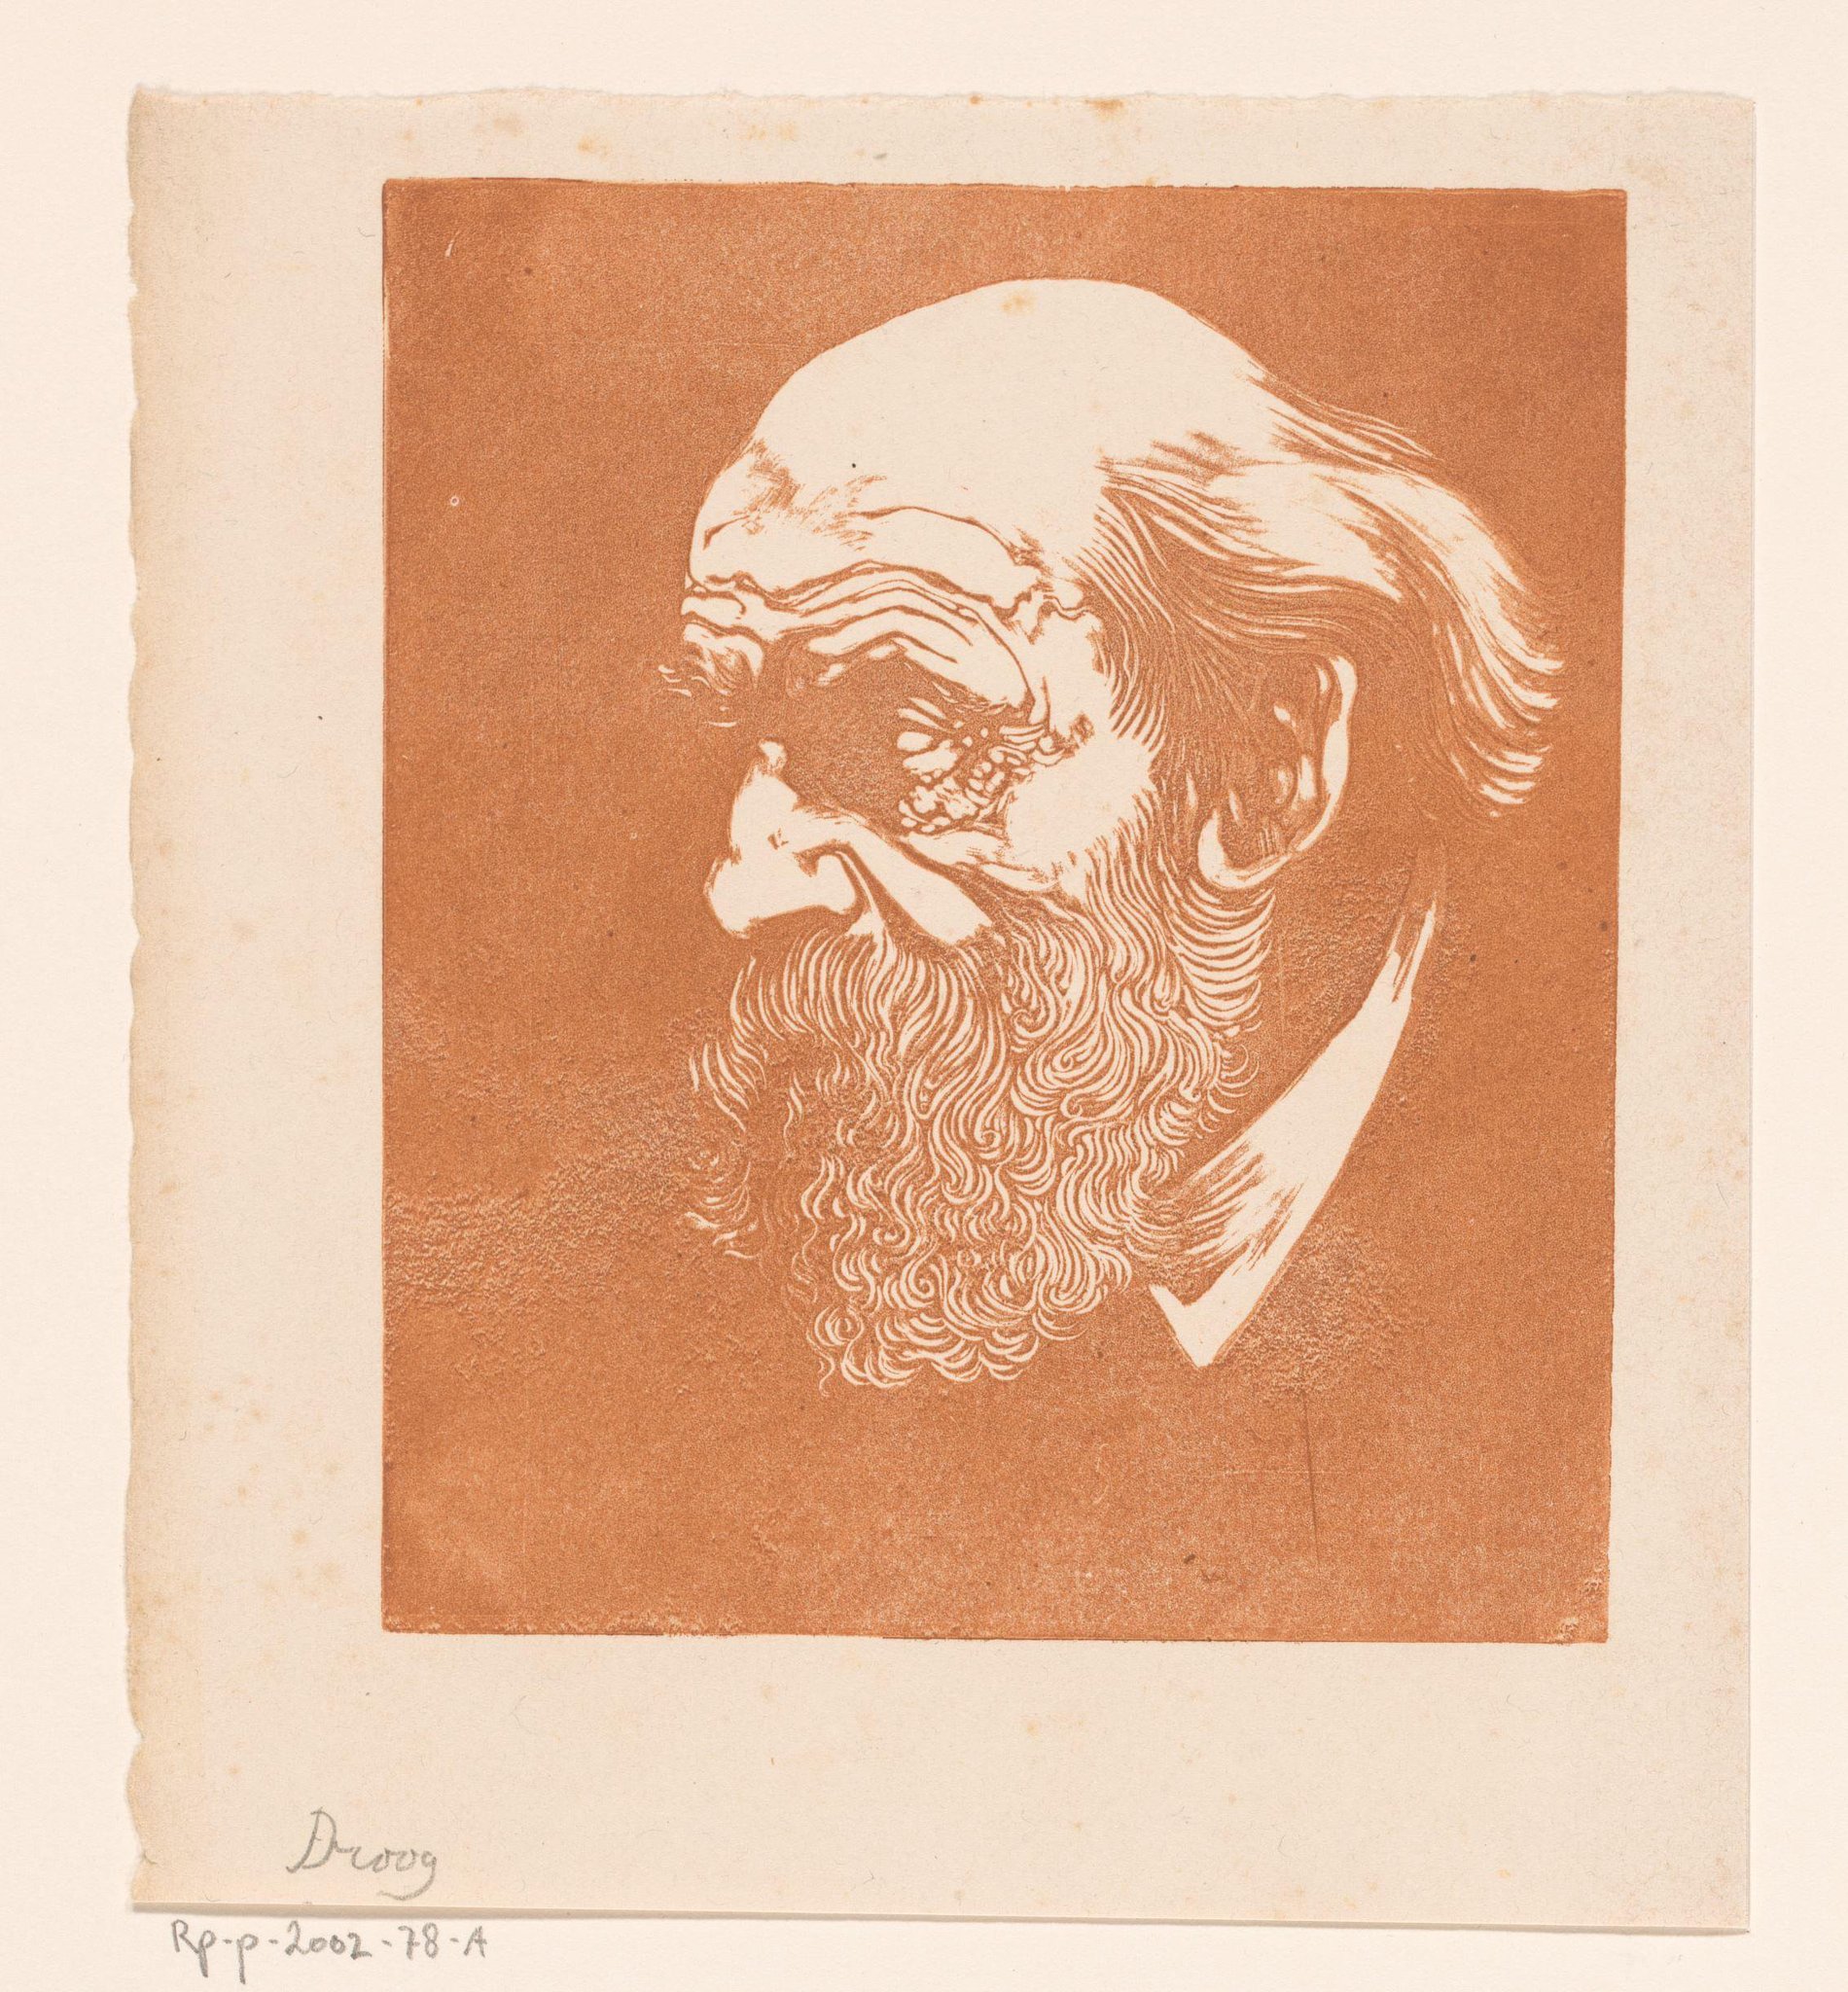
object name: print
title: Portret van Pierre Cuypers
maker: bernard willem wierink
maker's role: draughtsman, print maker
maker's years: 1856-1939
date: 1918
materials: paper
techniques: relief print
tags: draughtsman, pierre joseph hubert cuypers, portrait, self-portrait of architect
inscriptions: inscription: ‘droog’, collector's mark: Lugt 2228, collector's mark: Lugt 2760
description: Deze prent is vermoedelijk een plaatsnede, ook al wordt in de literatuur veelal gesproken over een houtsnede. Voor zover Wierink zijn prenten in hoogdruk zelf nader heeft omschreven, heeft hij altijd de term 'plaatsnede' gebruikt.